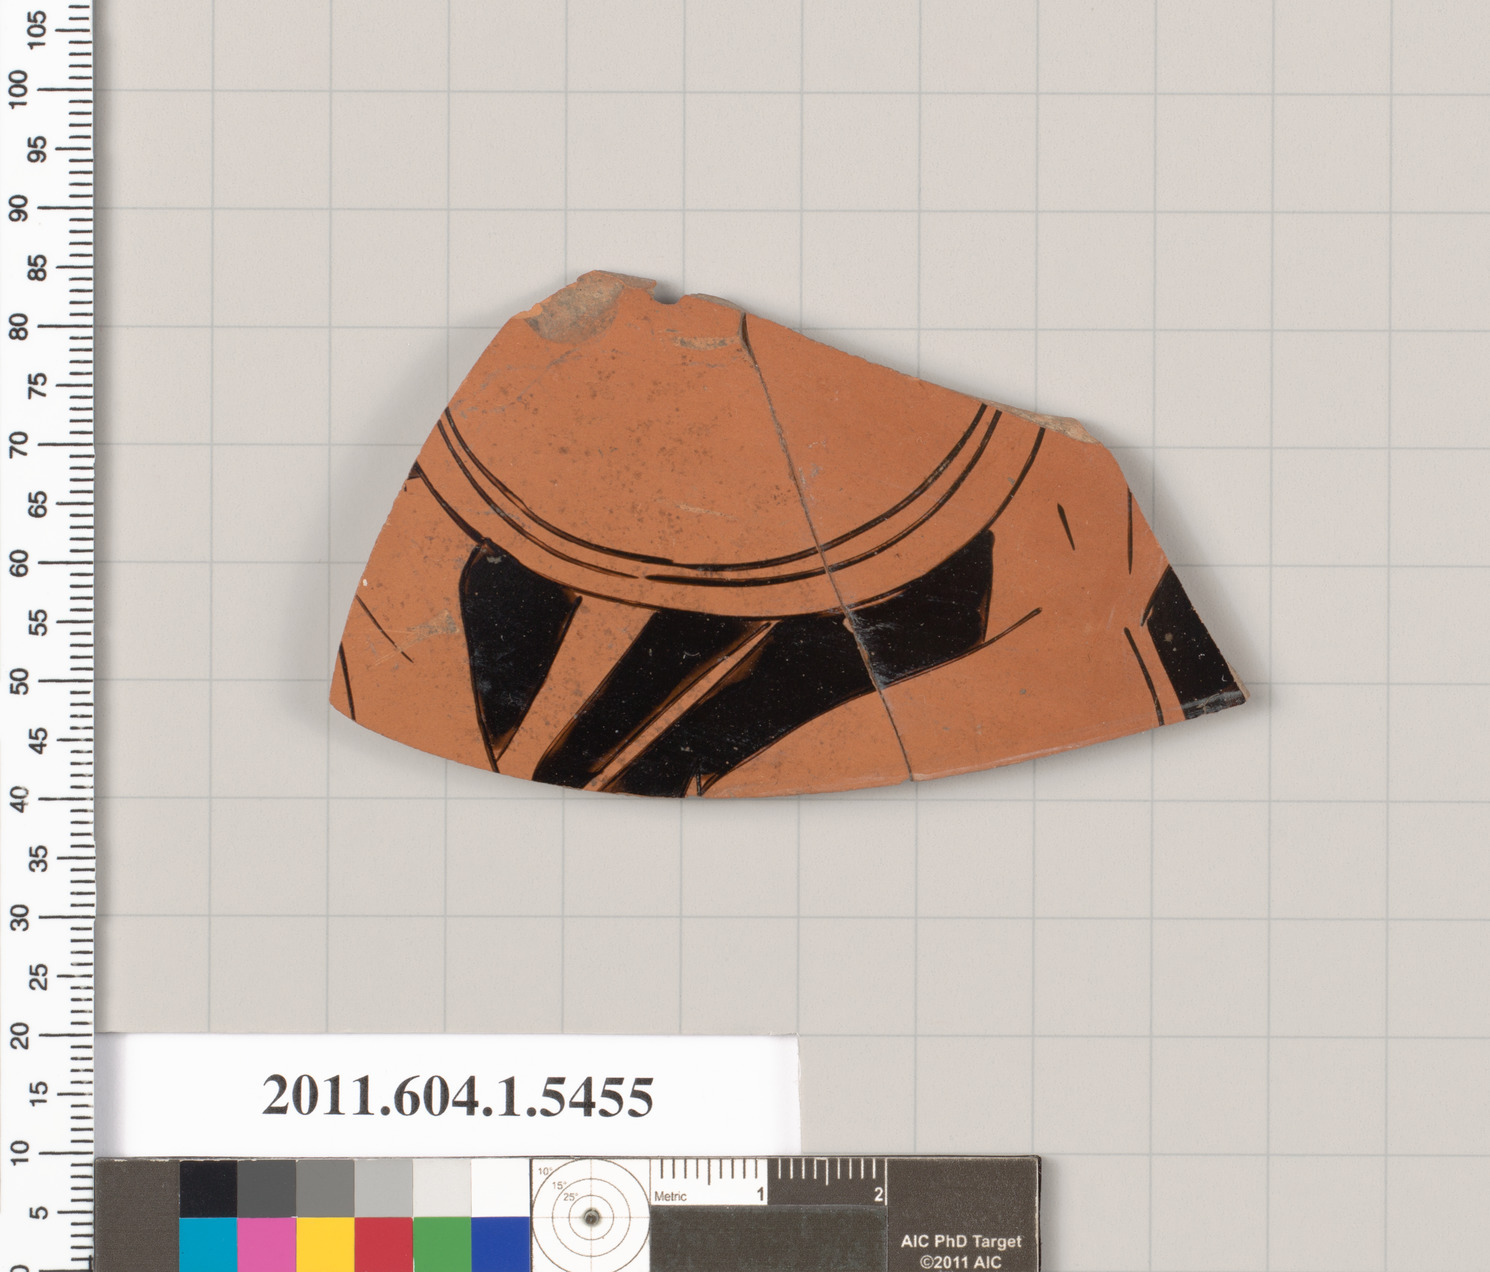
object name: kylix fragment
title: Terracotta fragment of a kylix (drinking cup)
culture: greek, attic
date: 520-510 BCE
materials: terracotta